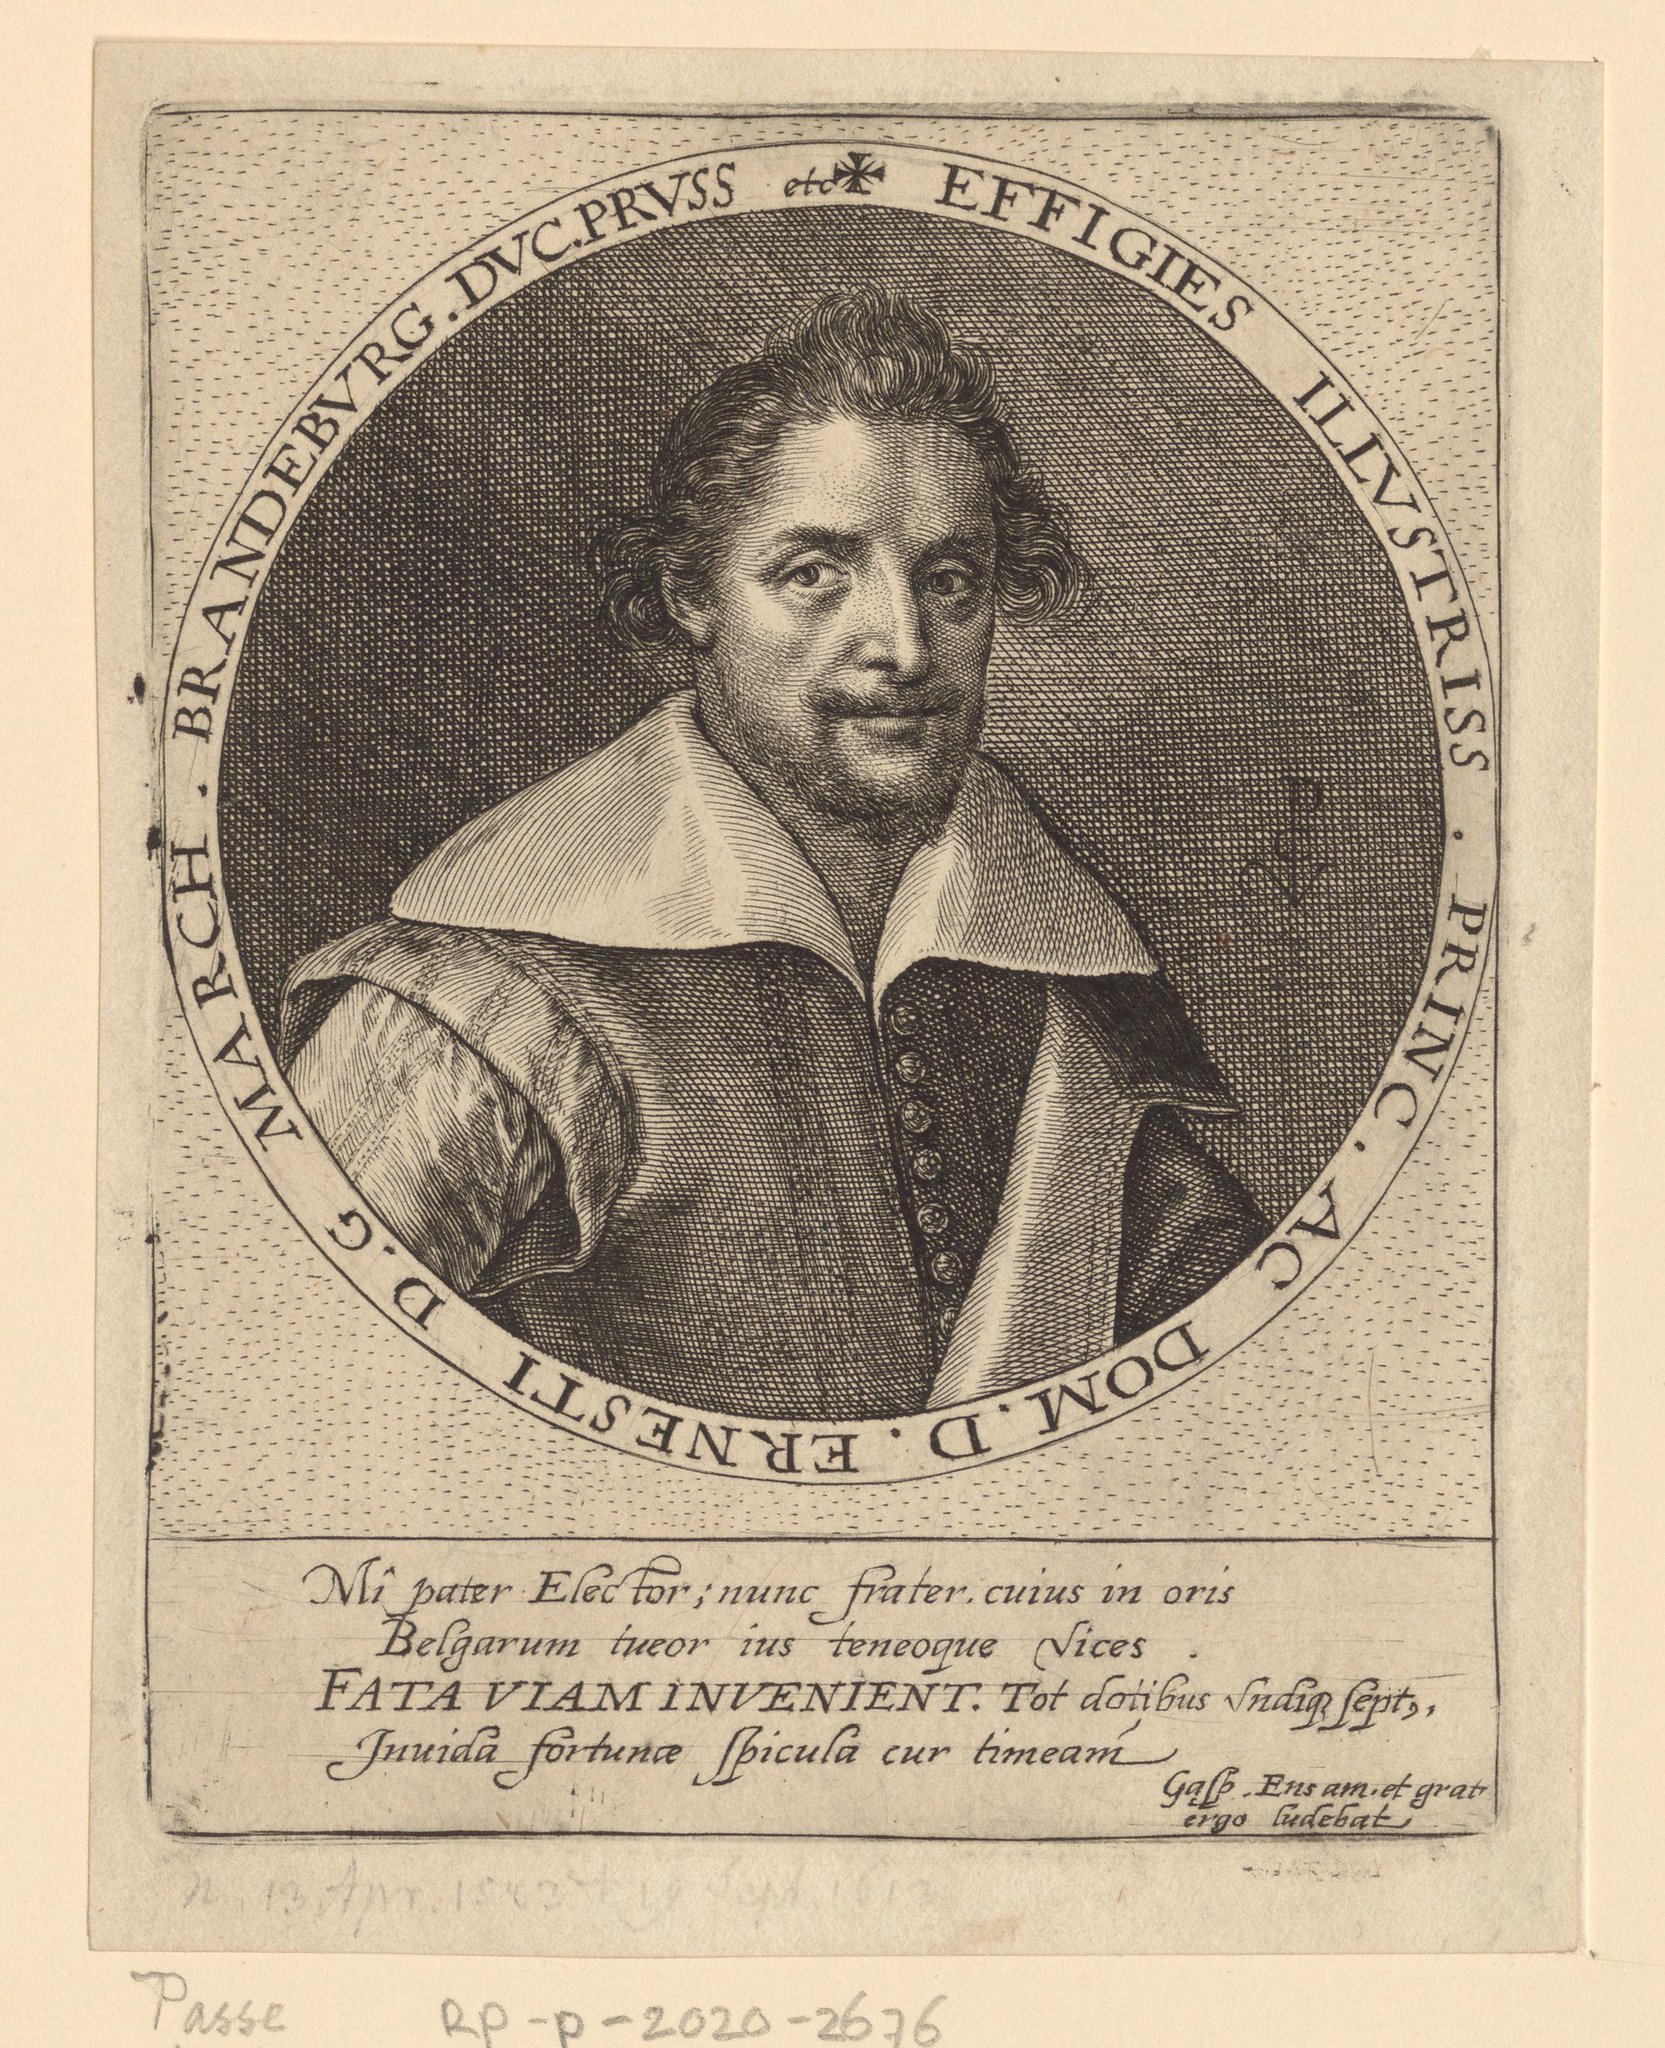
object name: print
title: Portret van Ernst, markgraaf van Brandenburg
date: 1610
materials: paper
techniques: engraving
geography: cologne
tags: historical persons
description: Prent waarschijnlijk uit: Des Fürstlichen Geschlechts und Hauses Gülich, Clev, Berg und Mark. Stamm Register (...). Arnhem: Jan Jansen, 1610.